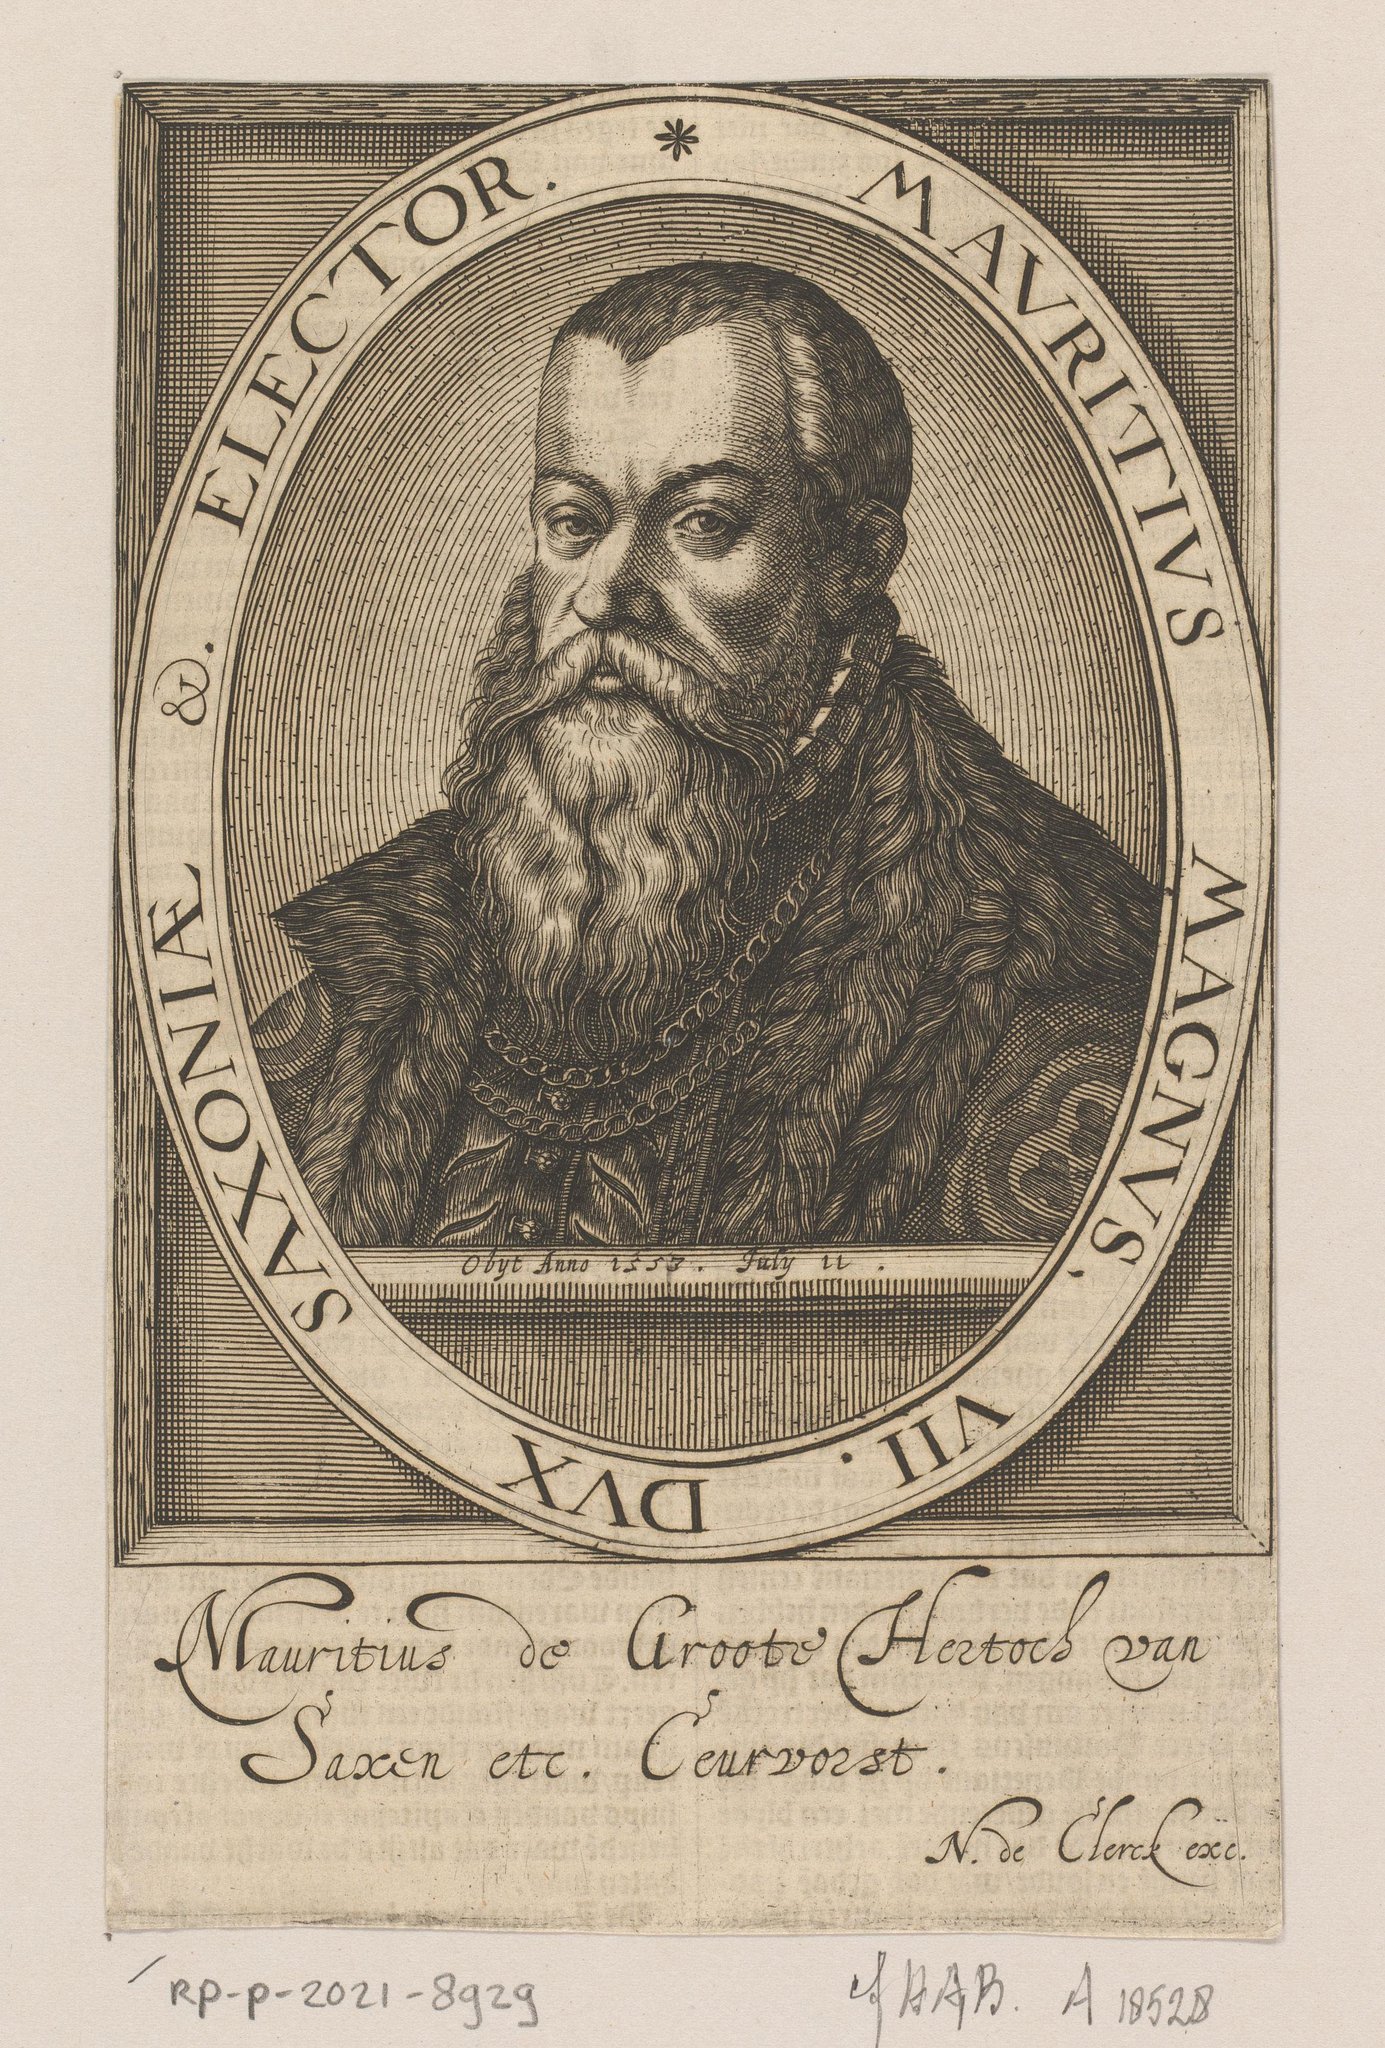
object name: book illustration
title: Portret van Maurits van Saksen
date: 1610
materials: paper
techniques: engraving, letterpress printing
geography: delft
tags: ornament ~ medallion, historical persons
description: Prent uit: Ulloa, Alfonso de. Historie, ende het leven van den aldermachtichsten ende victorieusten keyser (...). Delft: Adriaen Gerritsz., 1610. De prent is later gebruikt in: Tooneel der beroemder hertogen princen graven ende krygs-helden van christenrijck binnen deze drij laetste eeuwen. Delft: Nicolaes de Clerck, 1617.